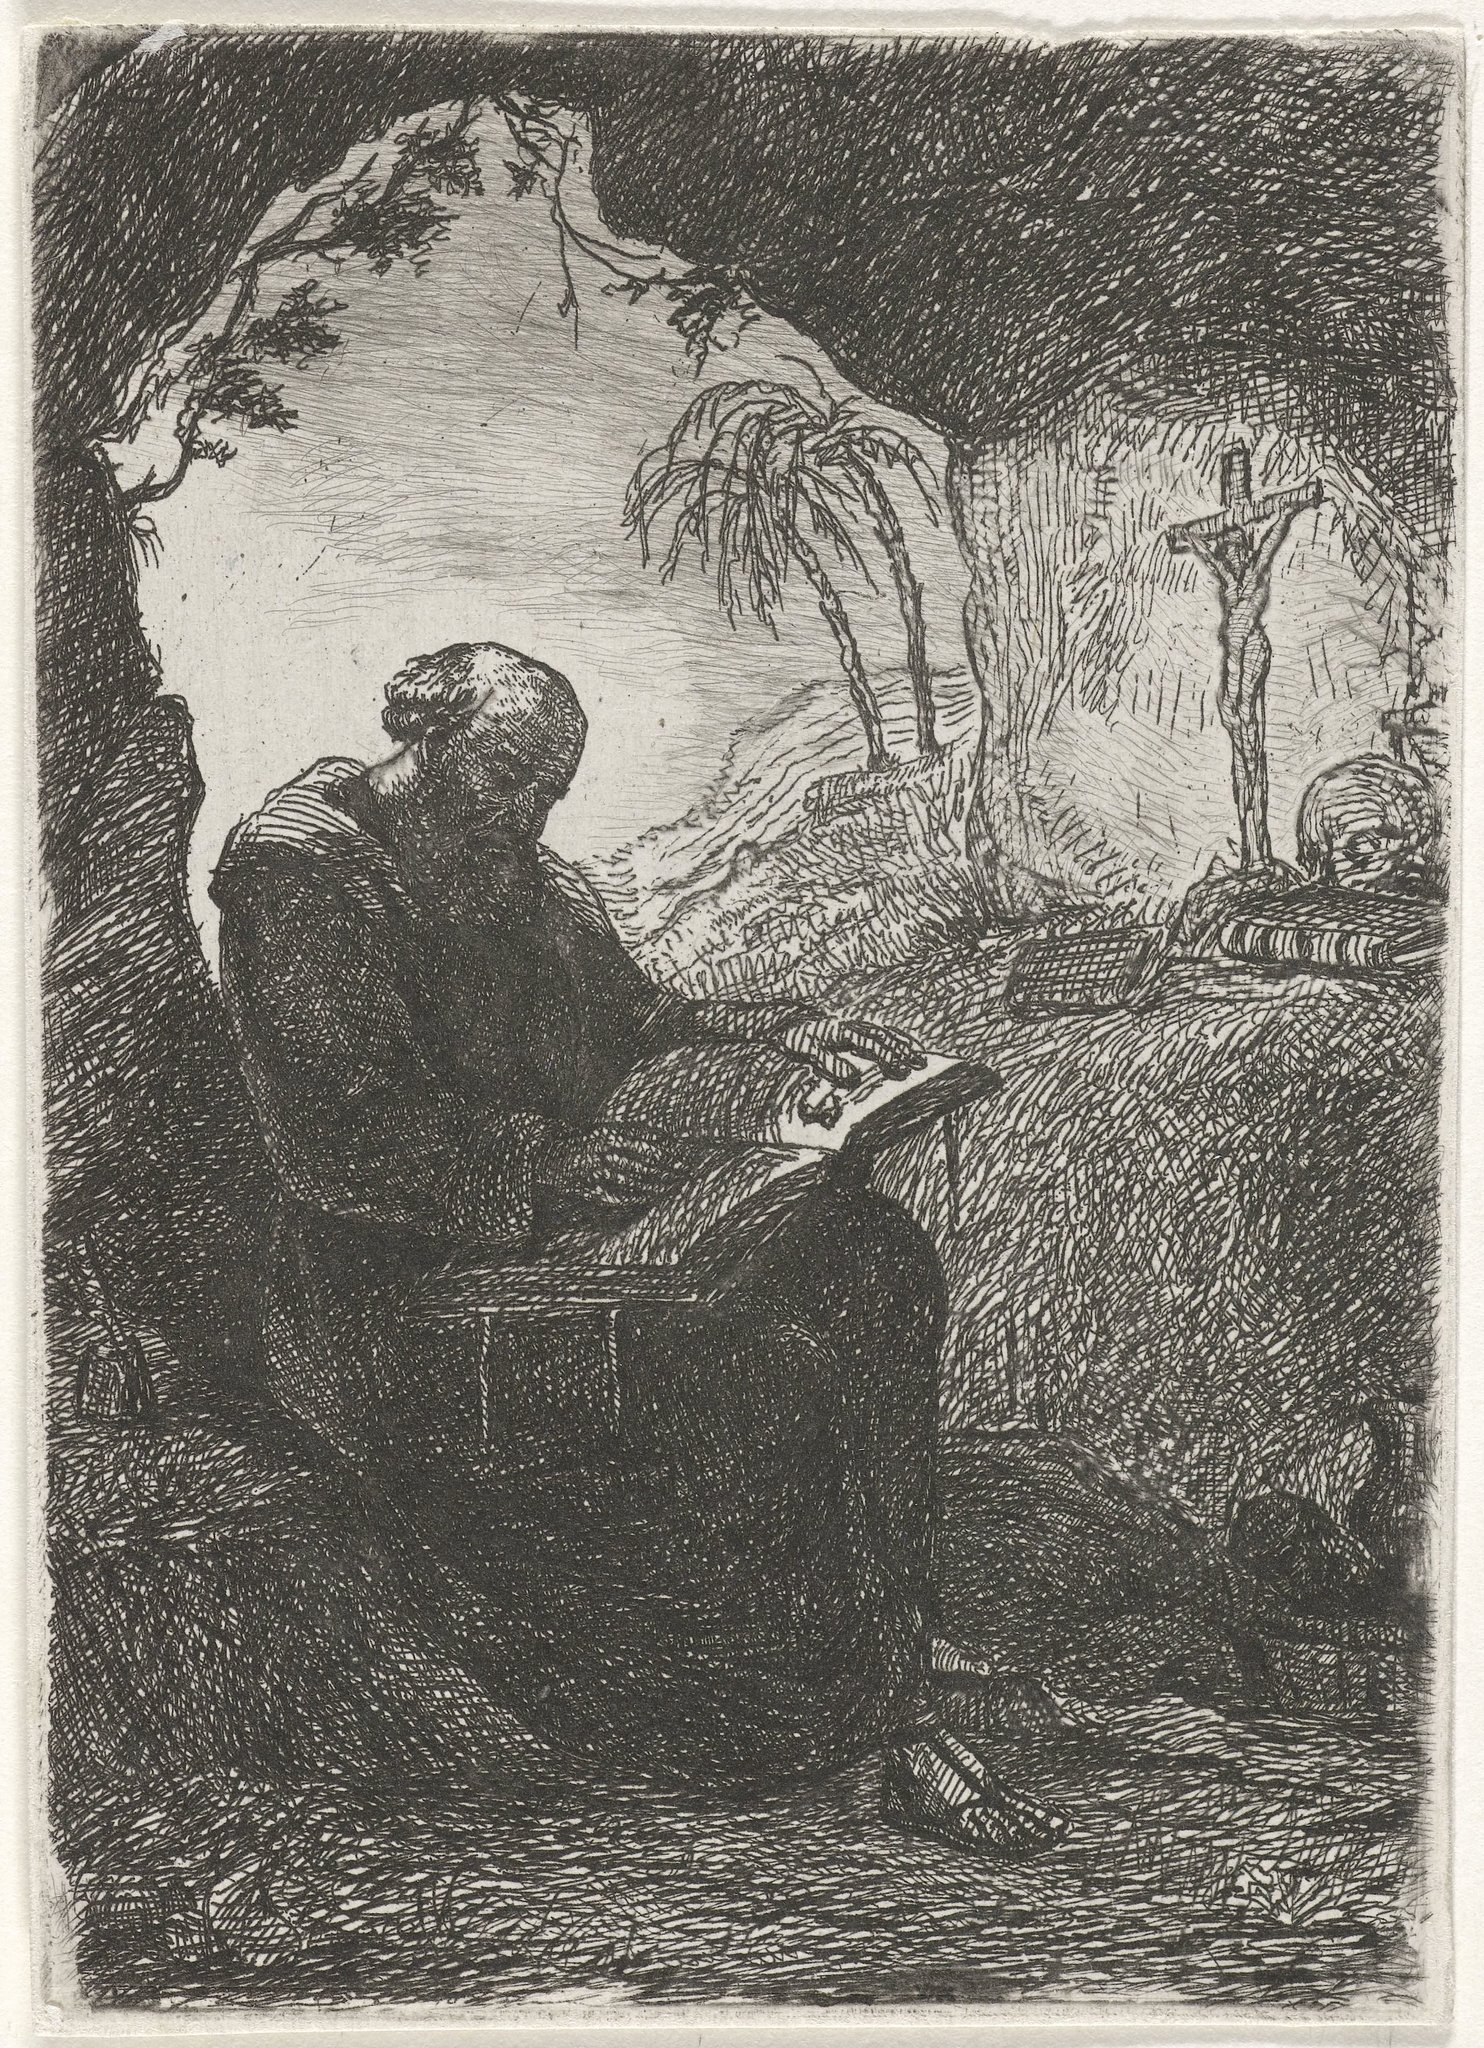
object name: print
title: Monnik in een grot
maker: david van der kellen (1804-1879)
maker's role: die cutter, draughtsman, print maker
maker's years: 1804-1879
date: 1814-1859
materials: paper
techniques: drypoint, etching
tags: reading, monk(s), friar(s), crucifix ~ personal devotion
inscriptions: collector's mark: Lugt 2228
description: Een monnik zit bij de ingang van een grot een boek te lezen. Voor hem een crucifix, een schedel en boeken. Op de achtergrond twee palmbomen op een heuvel.